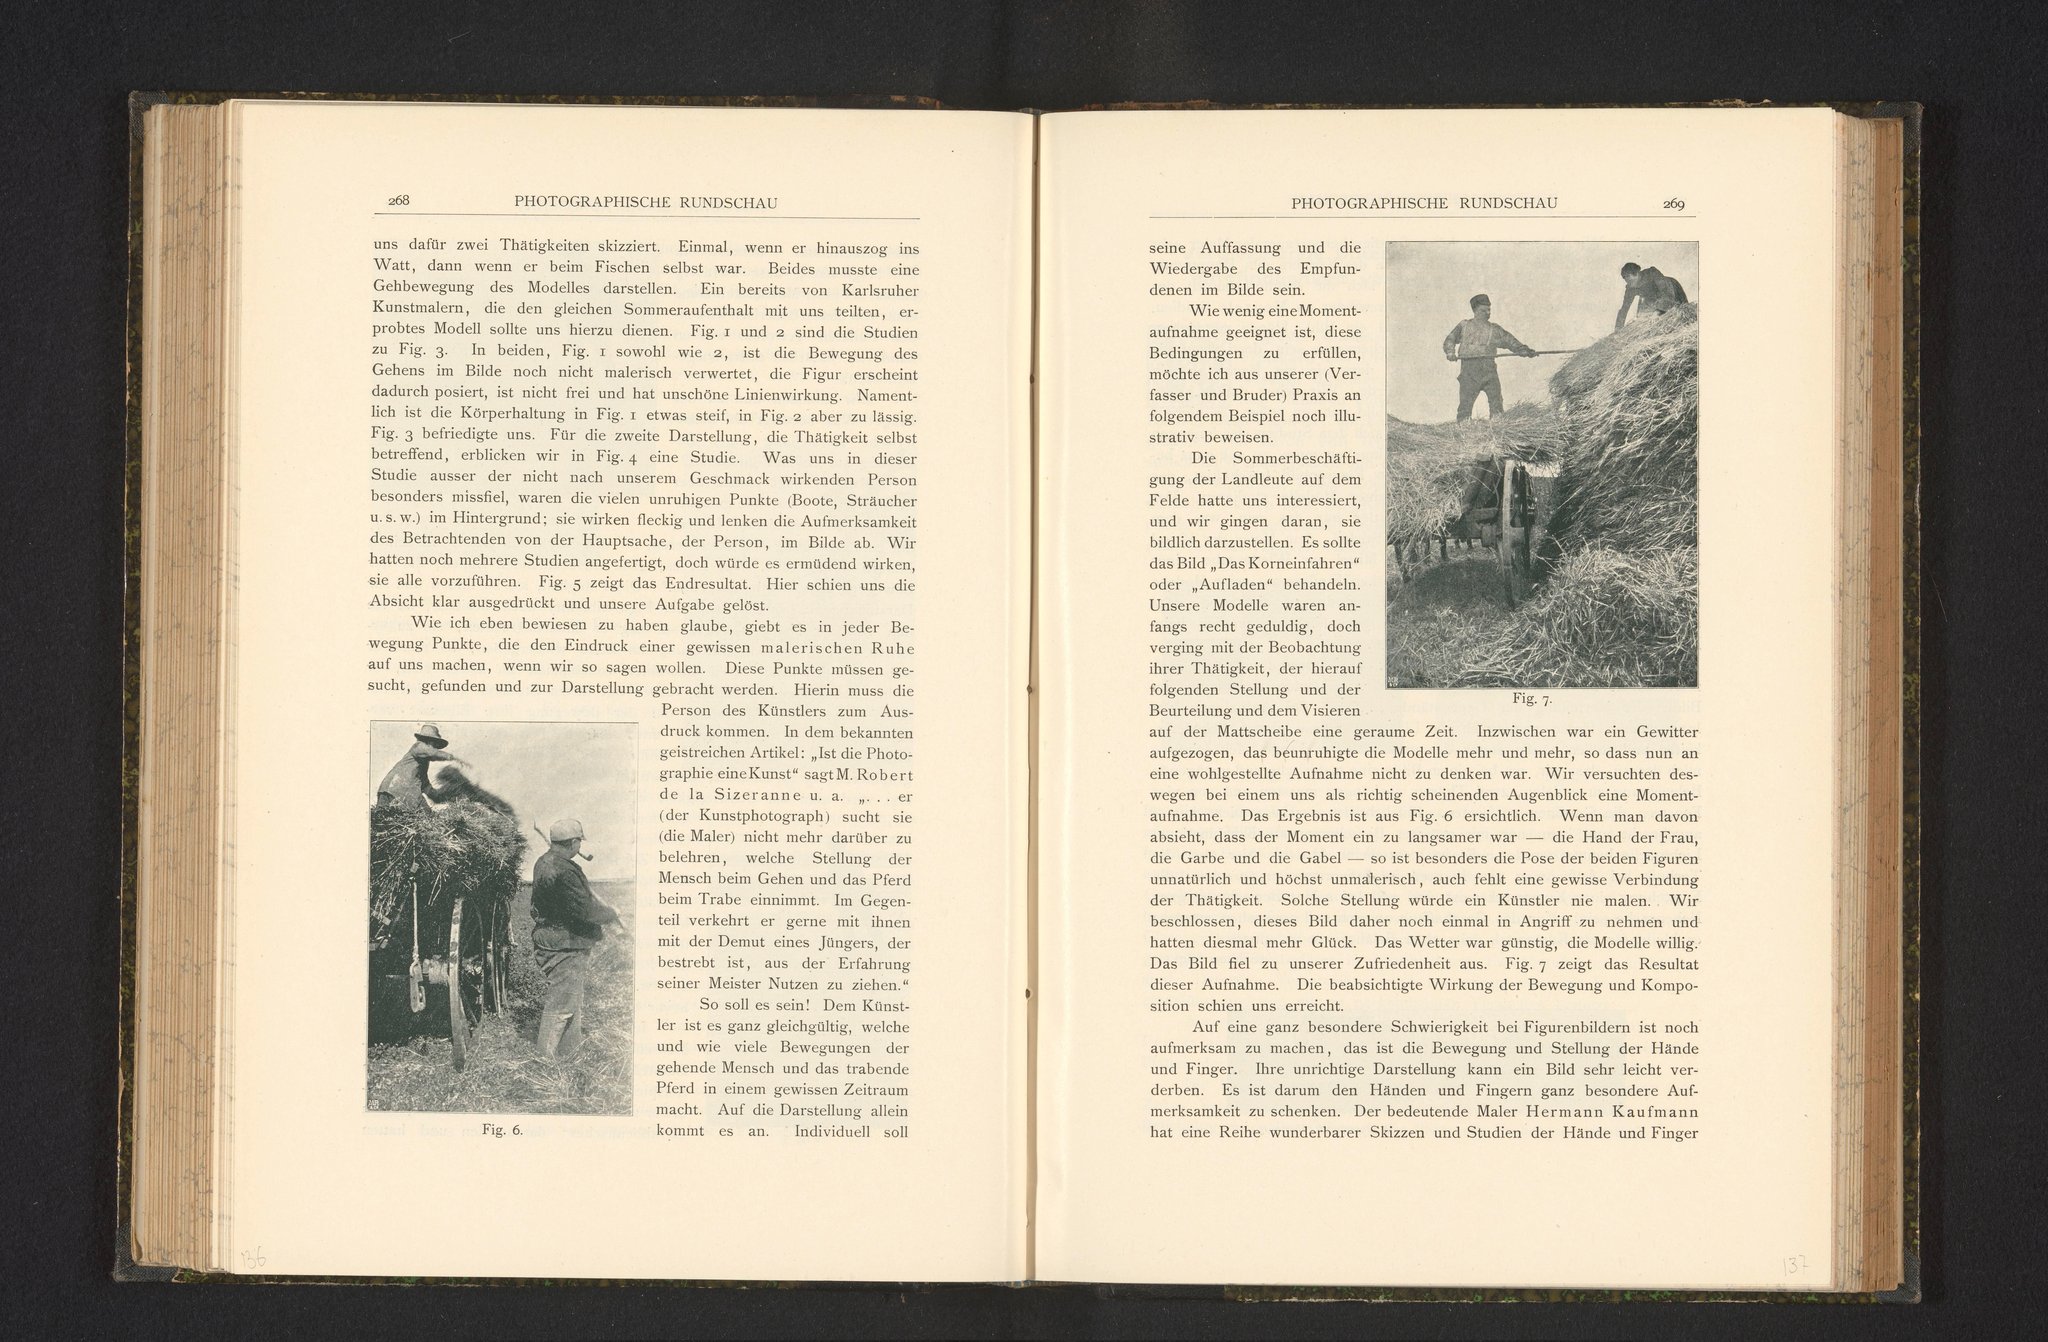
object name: photomechanical print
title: Gezicht op twee boeren die hooi op een kar verzamelen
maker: Anonymous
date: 1893-1898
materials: paper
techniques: autotype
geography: berlin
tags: agricultural products and by-products: hay, farmers, hay-wagon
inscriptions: monogram: ‘MR/ &Co’